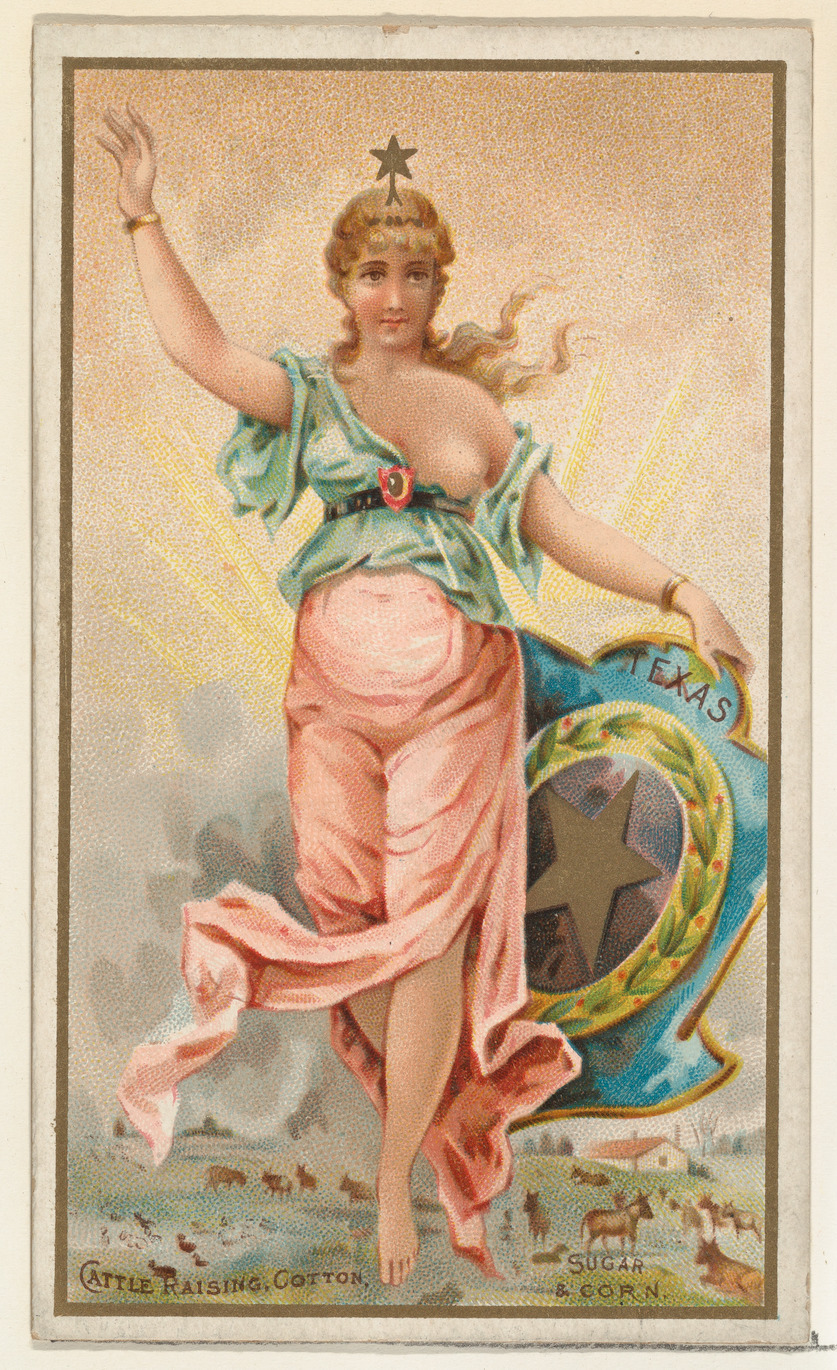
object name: print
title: Texas, from the Industries of States series (N117) issued by Duke Sons & Co. to promote Honest Long Cut Tobacco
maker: w. duke, sons & co.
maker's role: publisher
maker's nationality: american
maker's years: 1870-1920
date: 1889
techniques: color lithograph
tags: shields,women